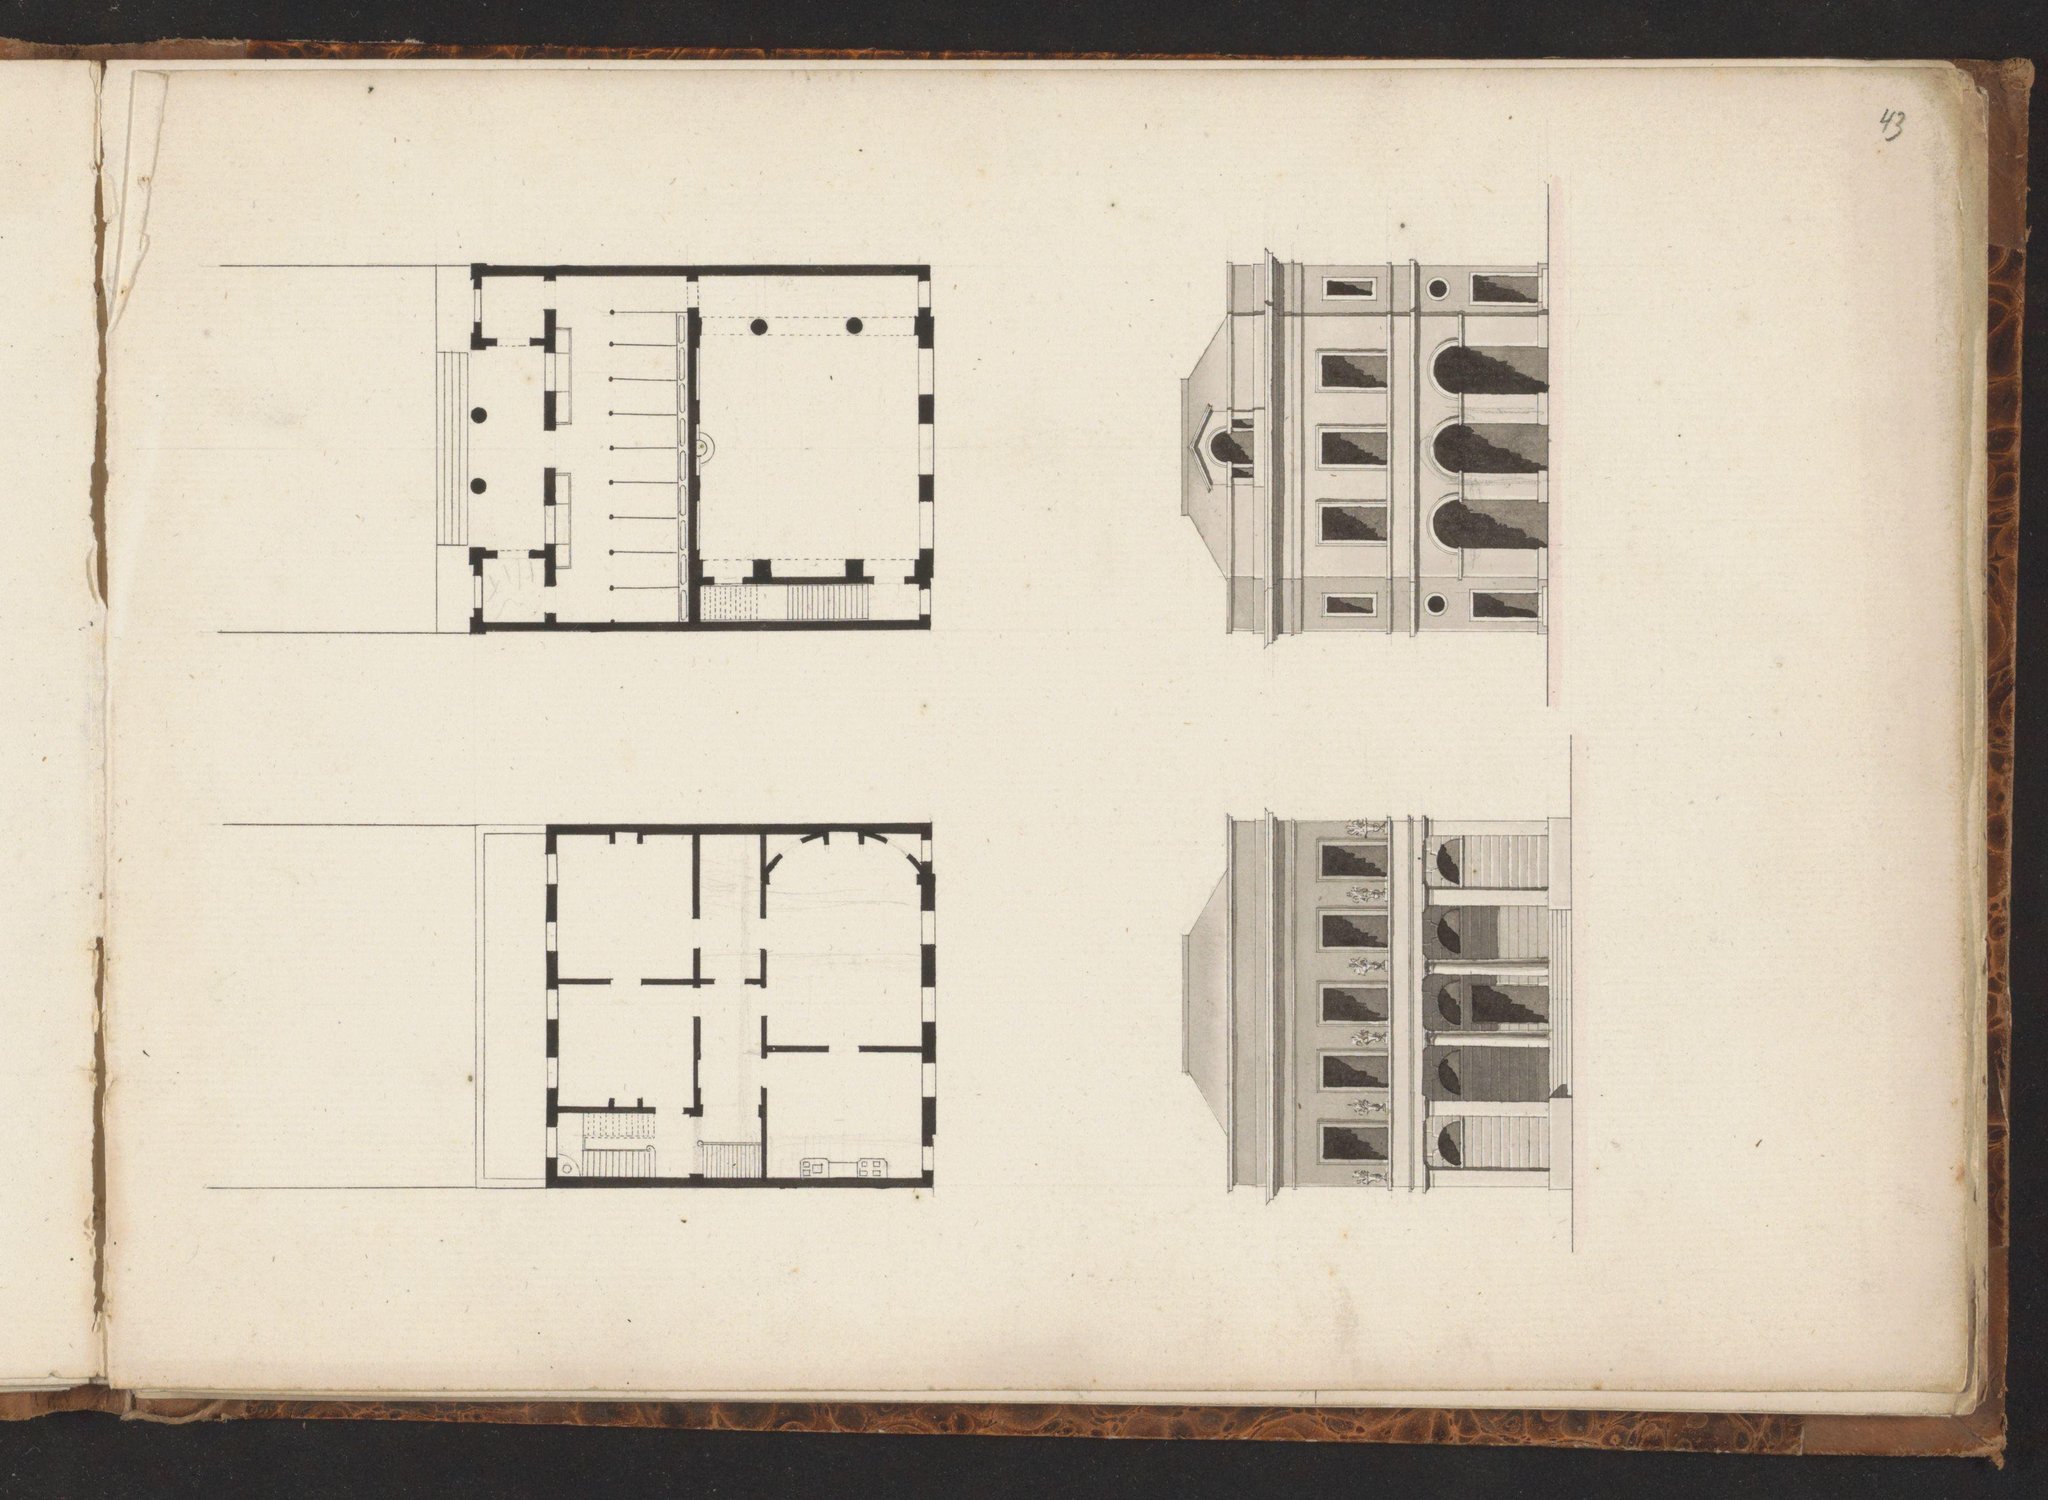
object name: sketchbook leaf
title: Plattegronden en voorgevels van twee villa's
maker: willem springer jr.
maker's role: draughtsman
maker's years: 1815-1907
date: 1825-1907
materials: ink, paper, pencil, watercolor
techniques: brush, pen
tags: villa, façade (of house or building), plan ~ architecture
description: Pagina 43 uit een schetsboek met 86 pagina's.